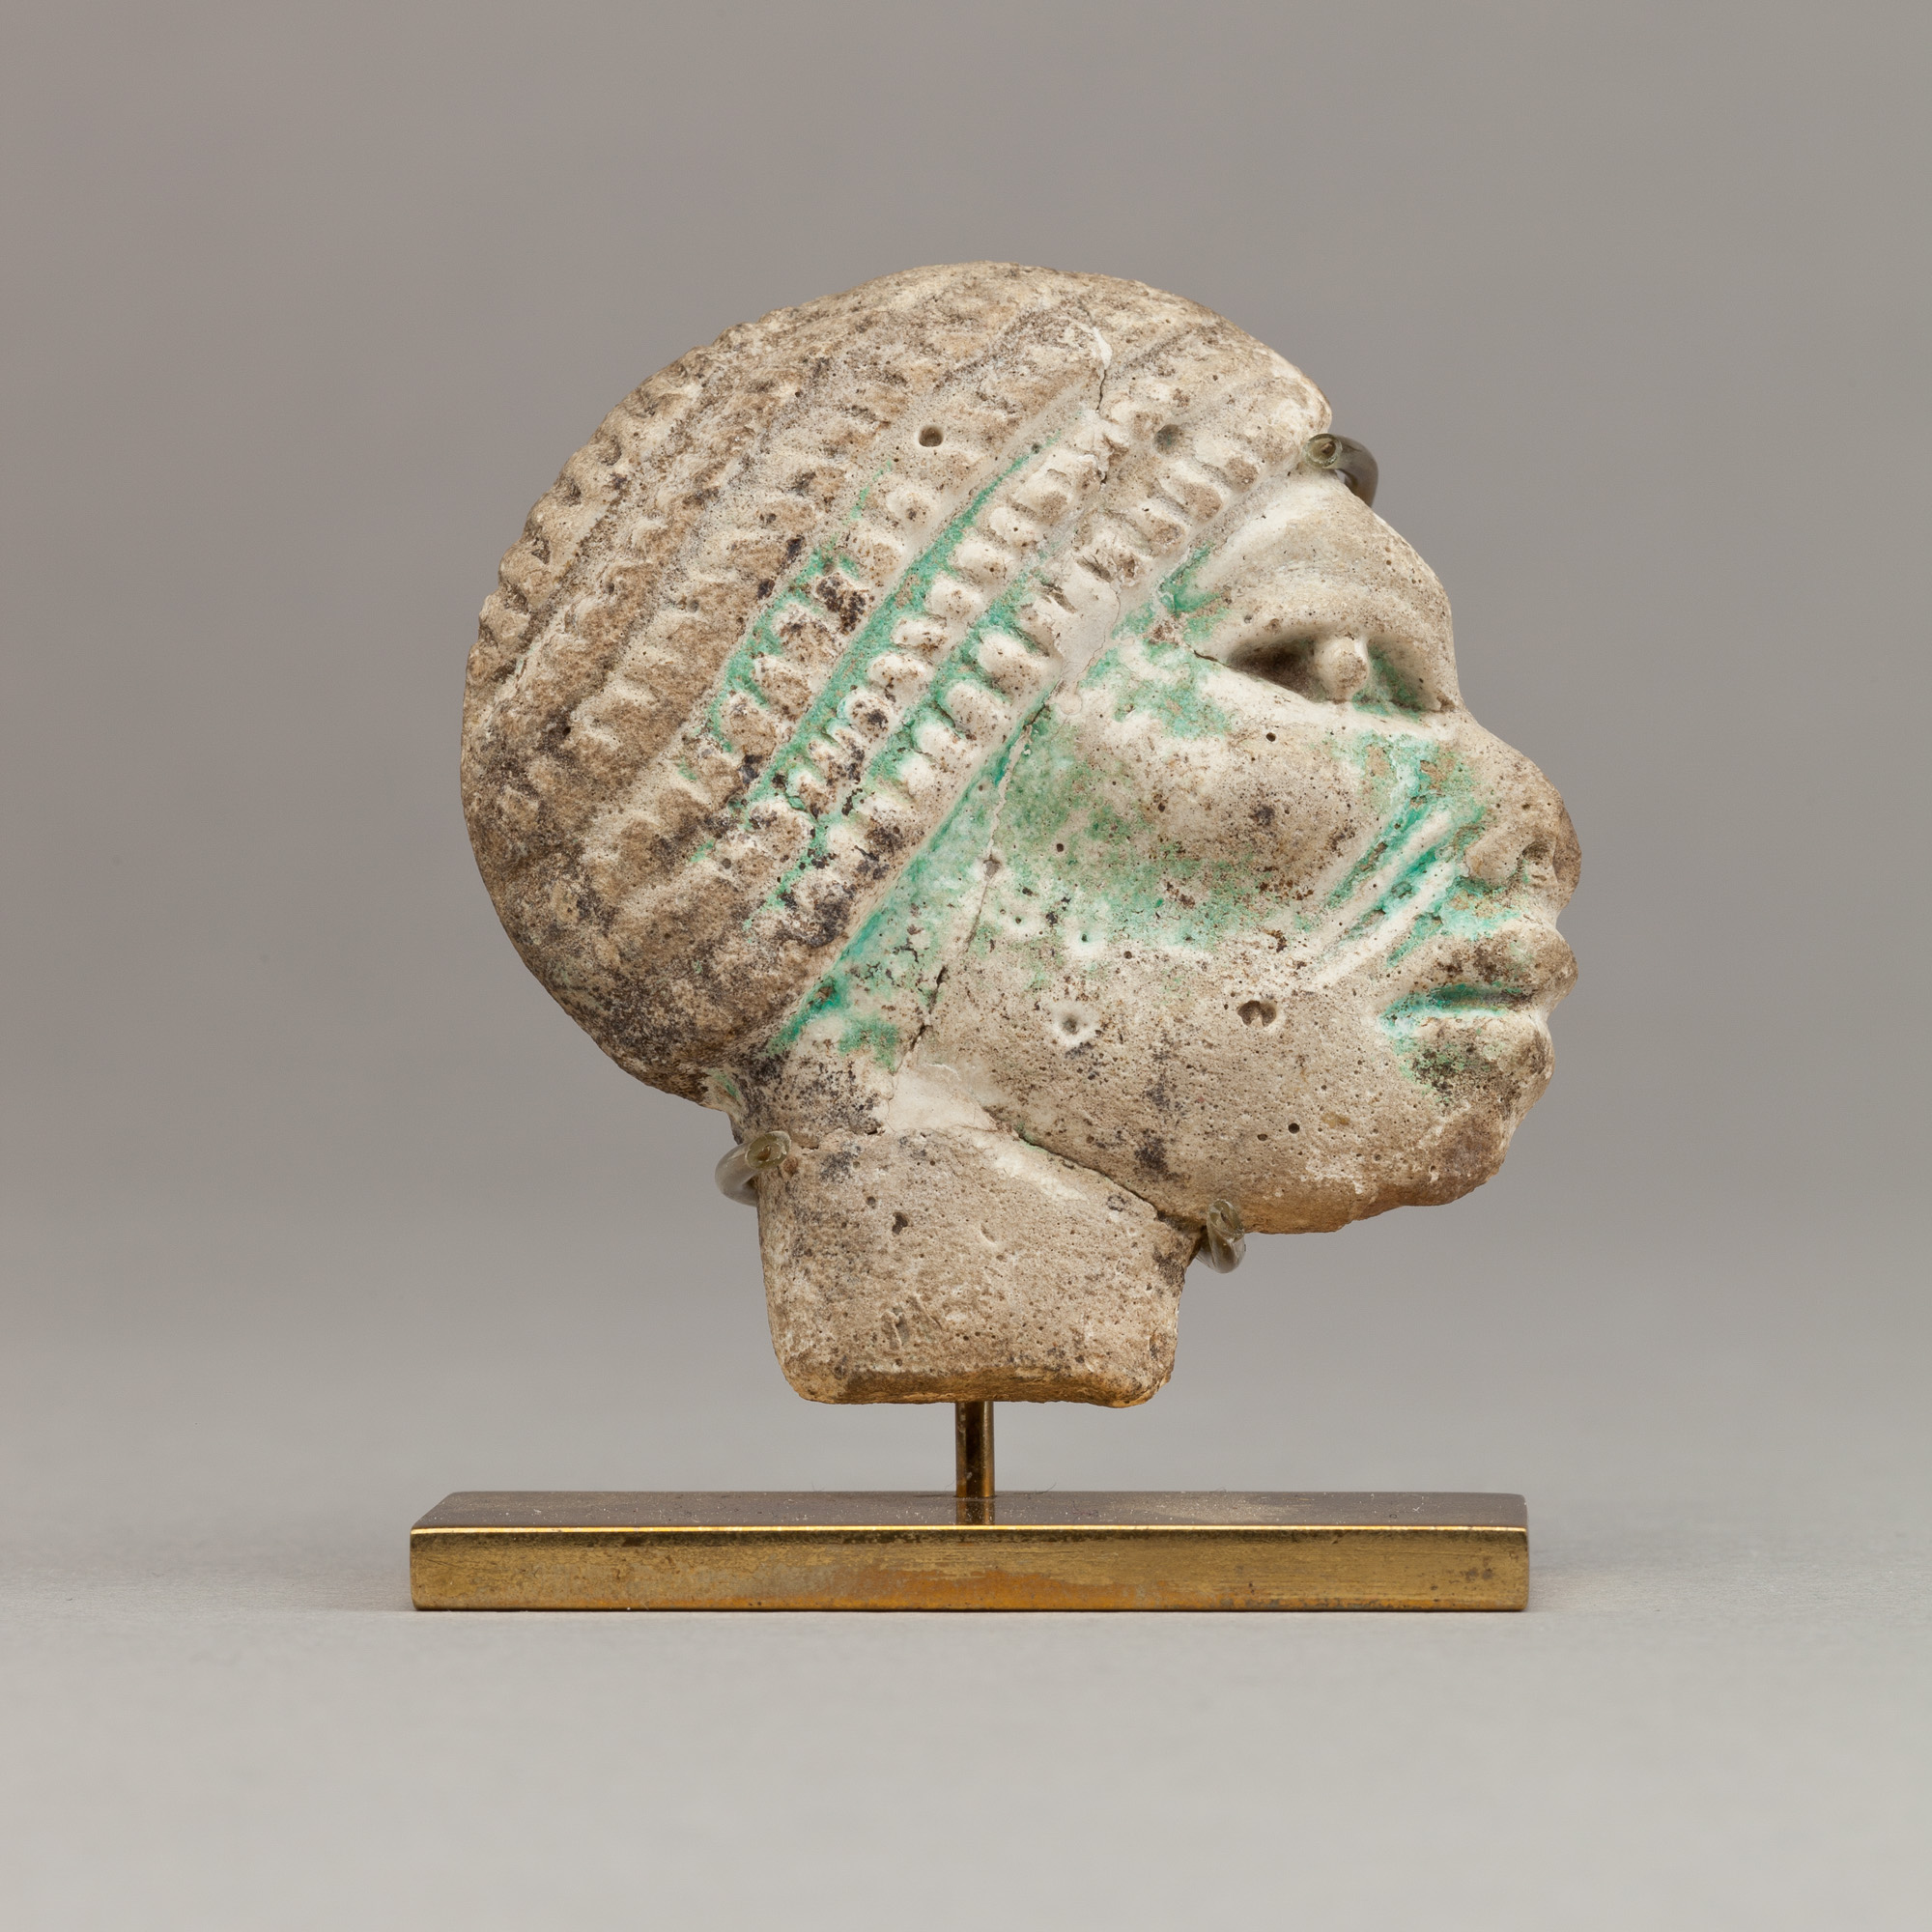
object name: inlay, nubian head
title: Nubian head inlay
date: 1295-1070 BCE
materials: faience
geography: egypt